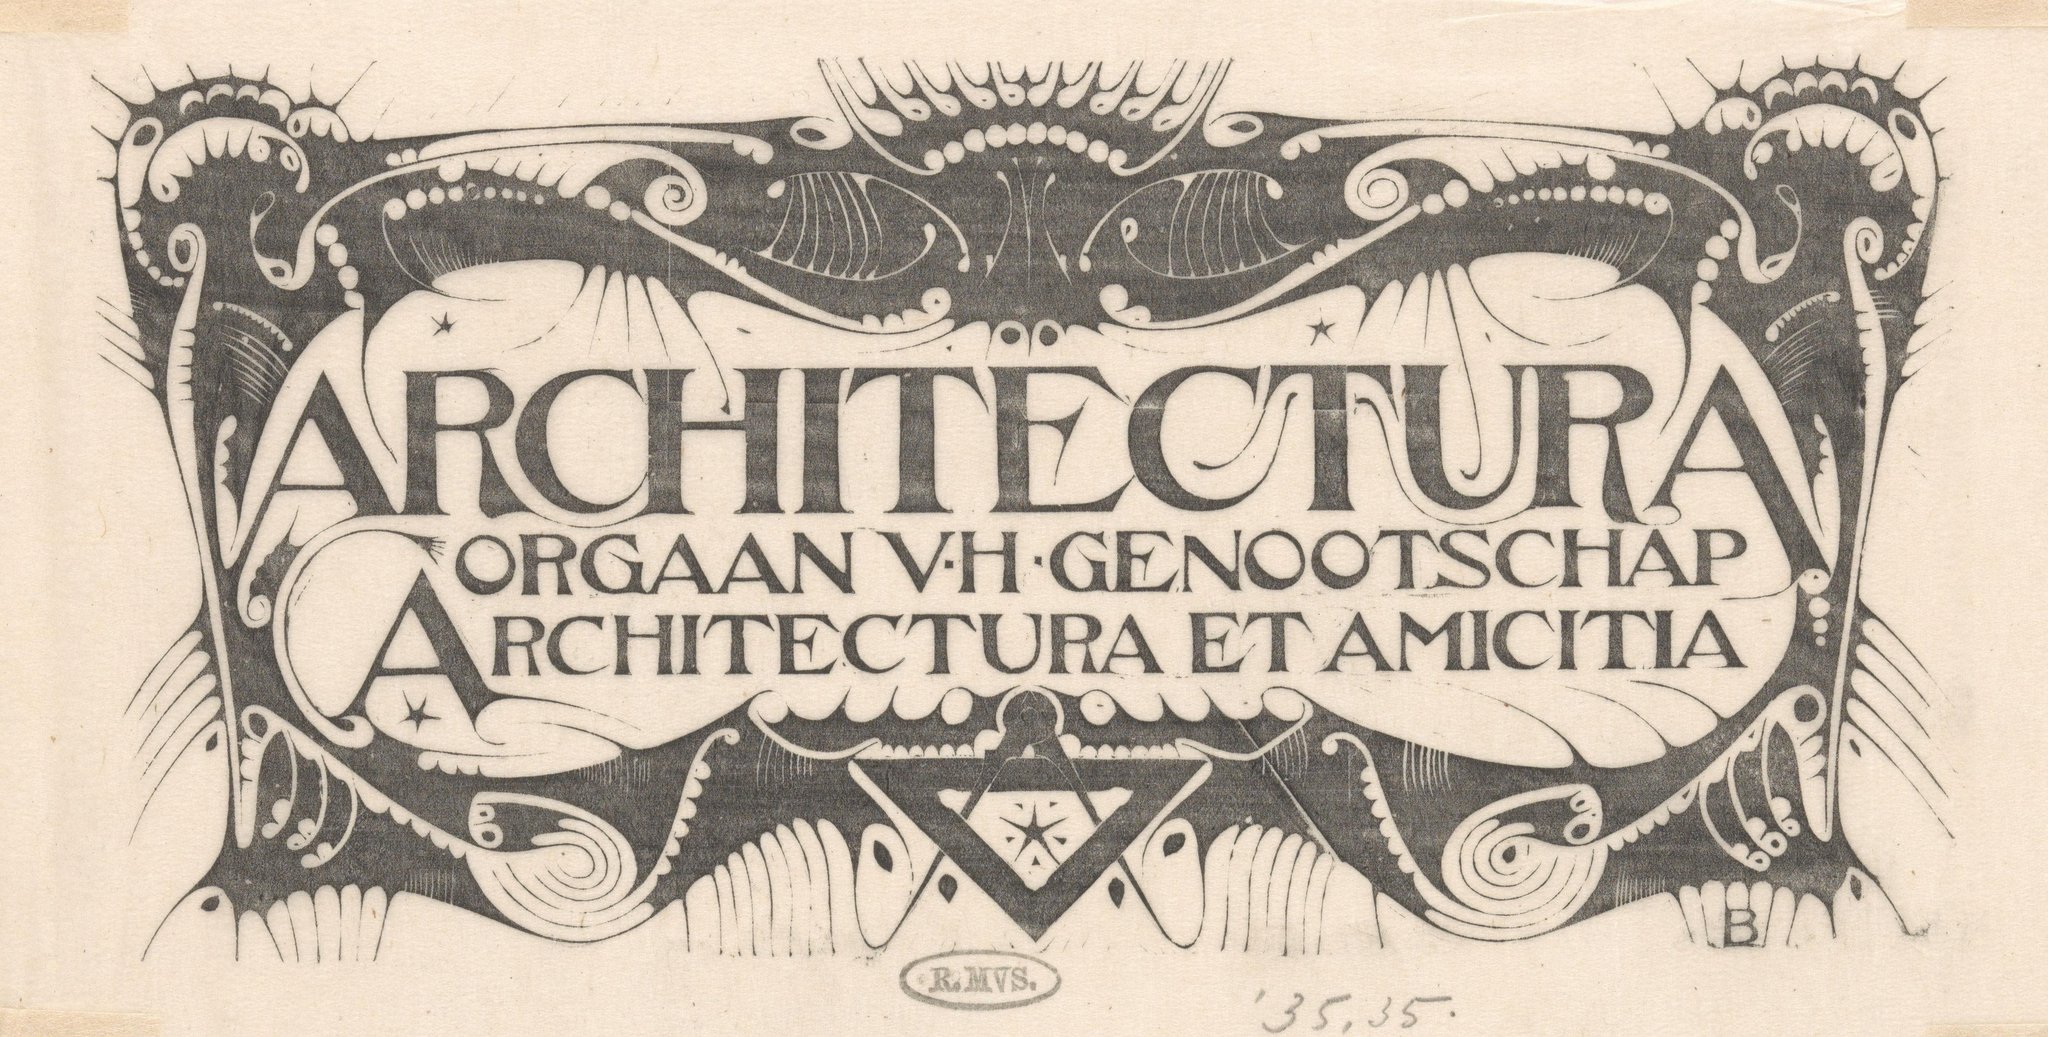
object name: print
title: Titelvignet voor Architectura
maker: karel petrus cornelis de bazel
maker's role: draughtsman, print maker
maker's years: 1869-1923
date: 1912-1934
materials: paper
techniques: woodcut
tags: vignette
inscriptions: collector's mark: Lugt 2228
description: Titelhoofd voor het bouwkundig tijdschrift 'Architectura', gebruikt voor jaargang vier (1896) en vijf (1897).